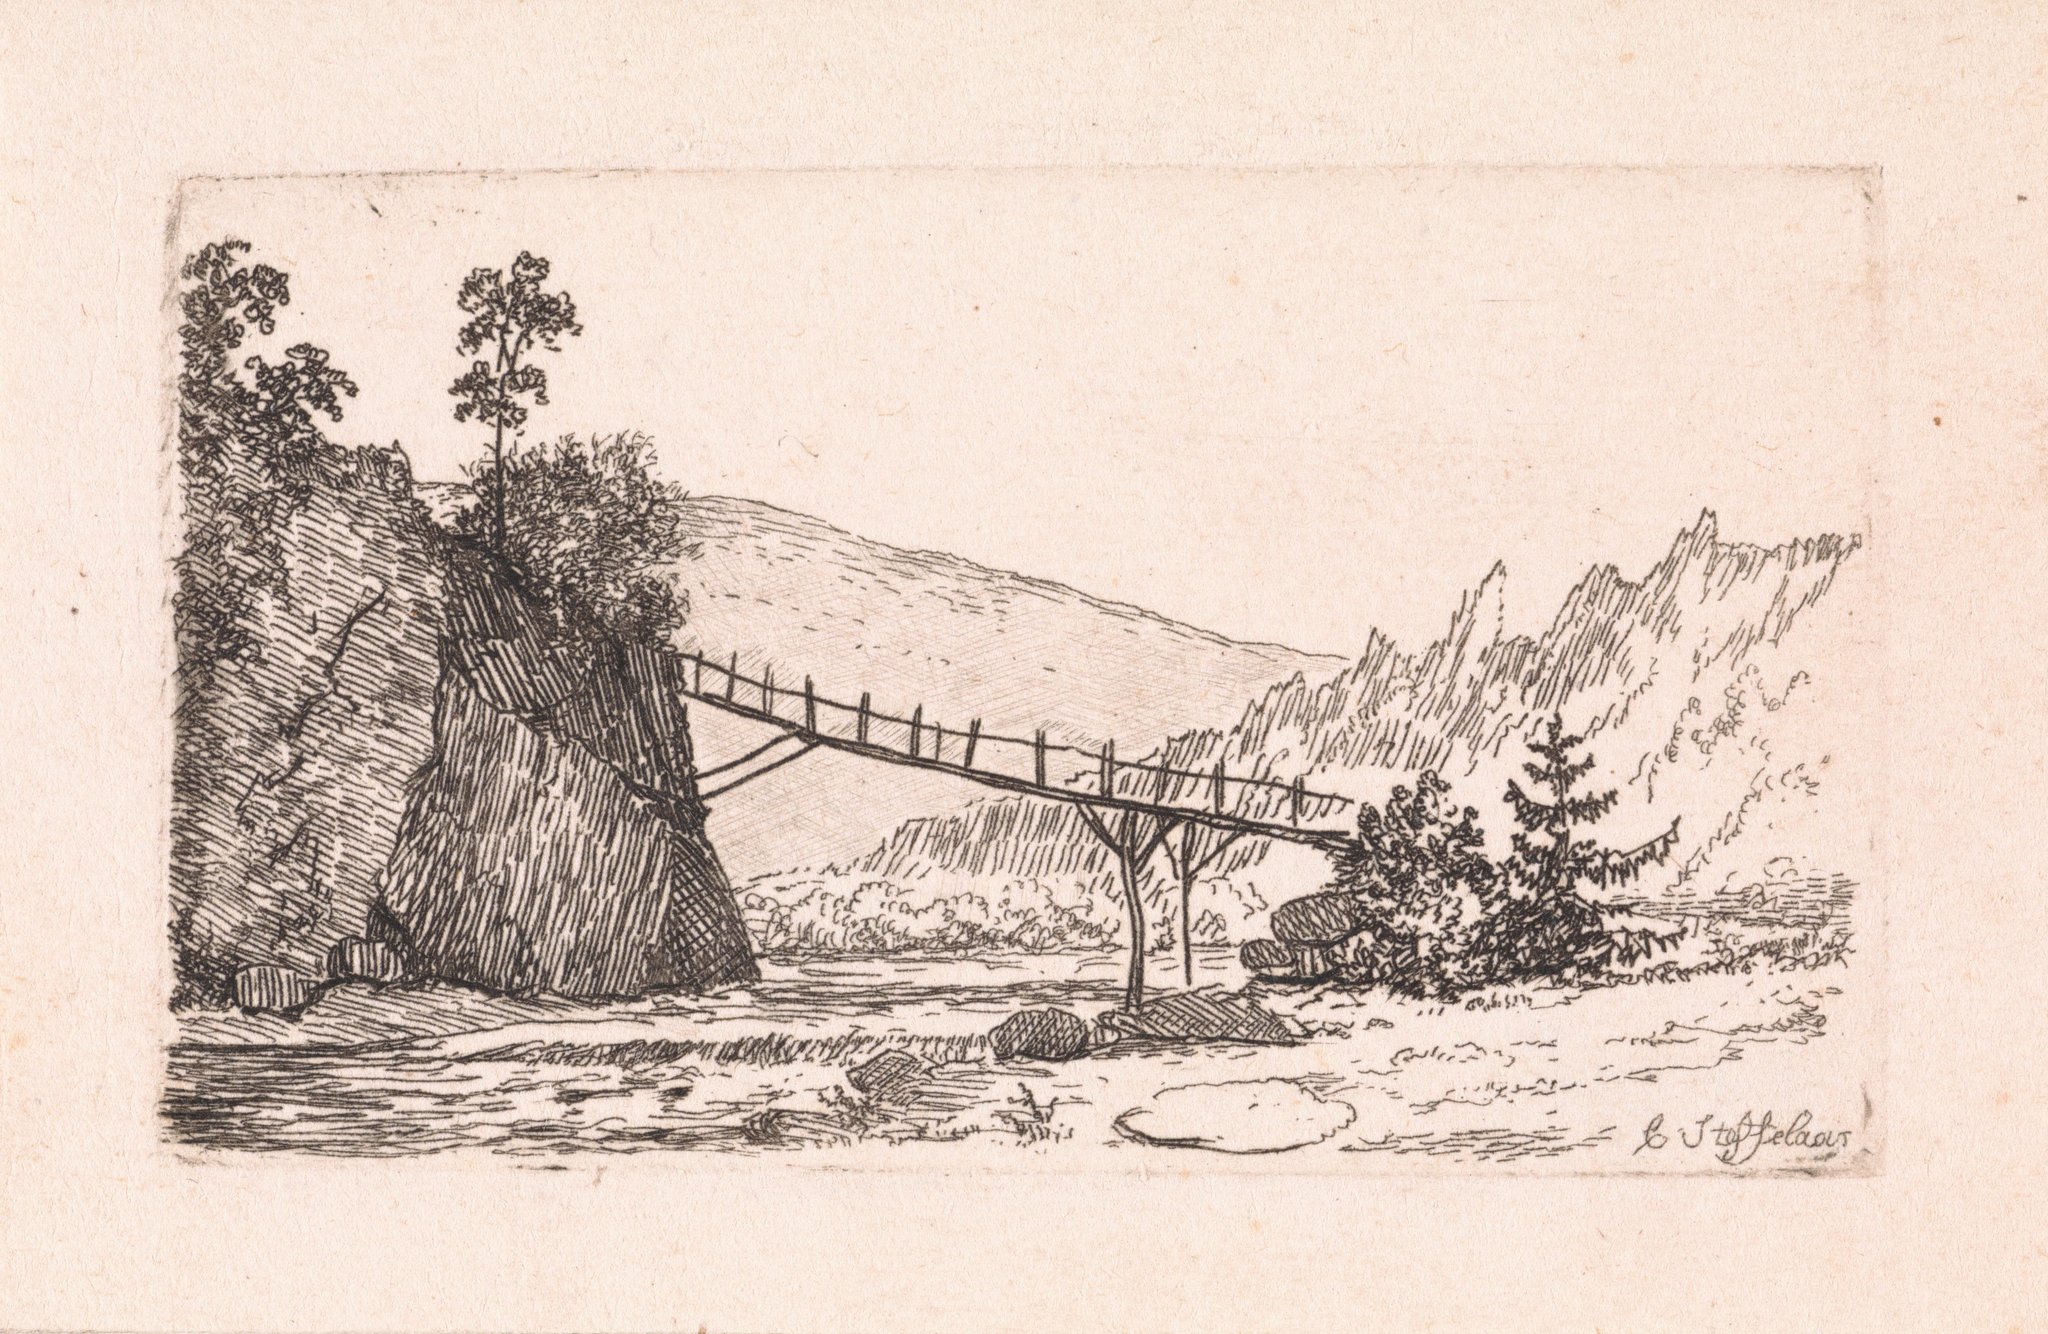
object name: print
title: Brug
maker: cornelis steffelaar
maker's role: draughtsman, painter, print maker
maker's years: 1797-1861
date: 1845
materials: paper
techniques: etching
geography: amsterdam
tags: landscape with bridge, viaduct or aqueduct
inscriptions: collector's mark: Lugt 2227